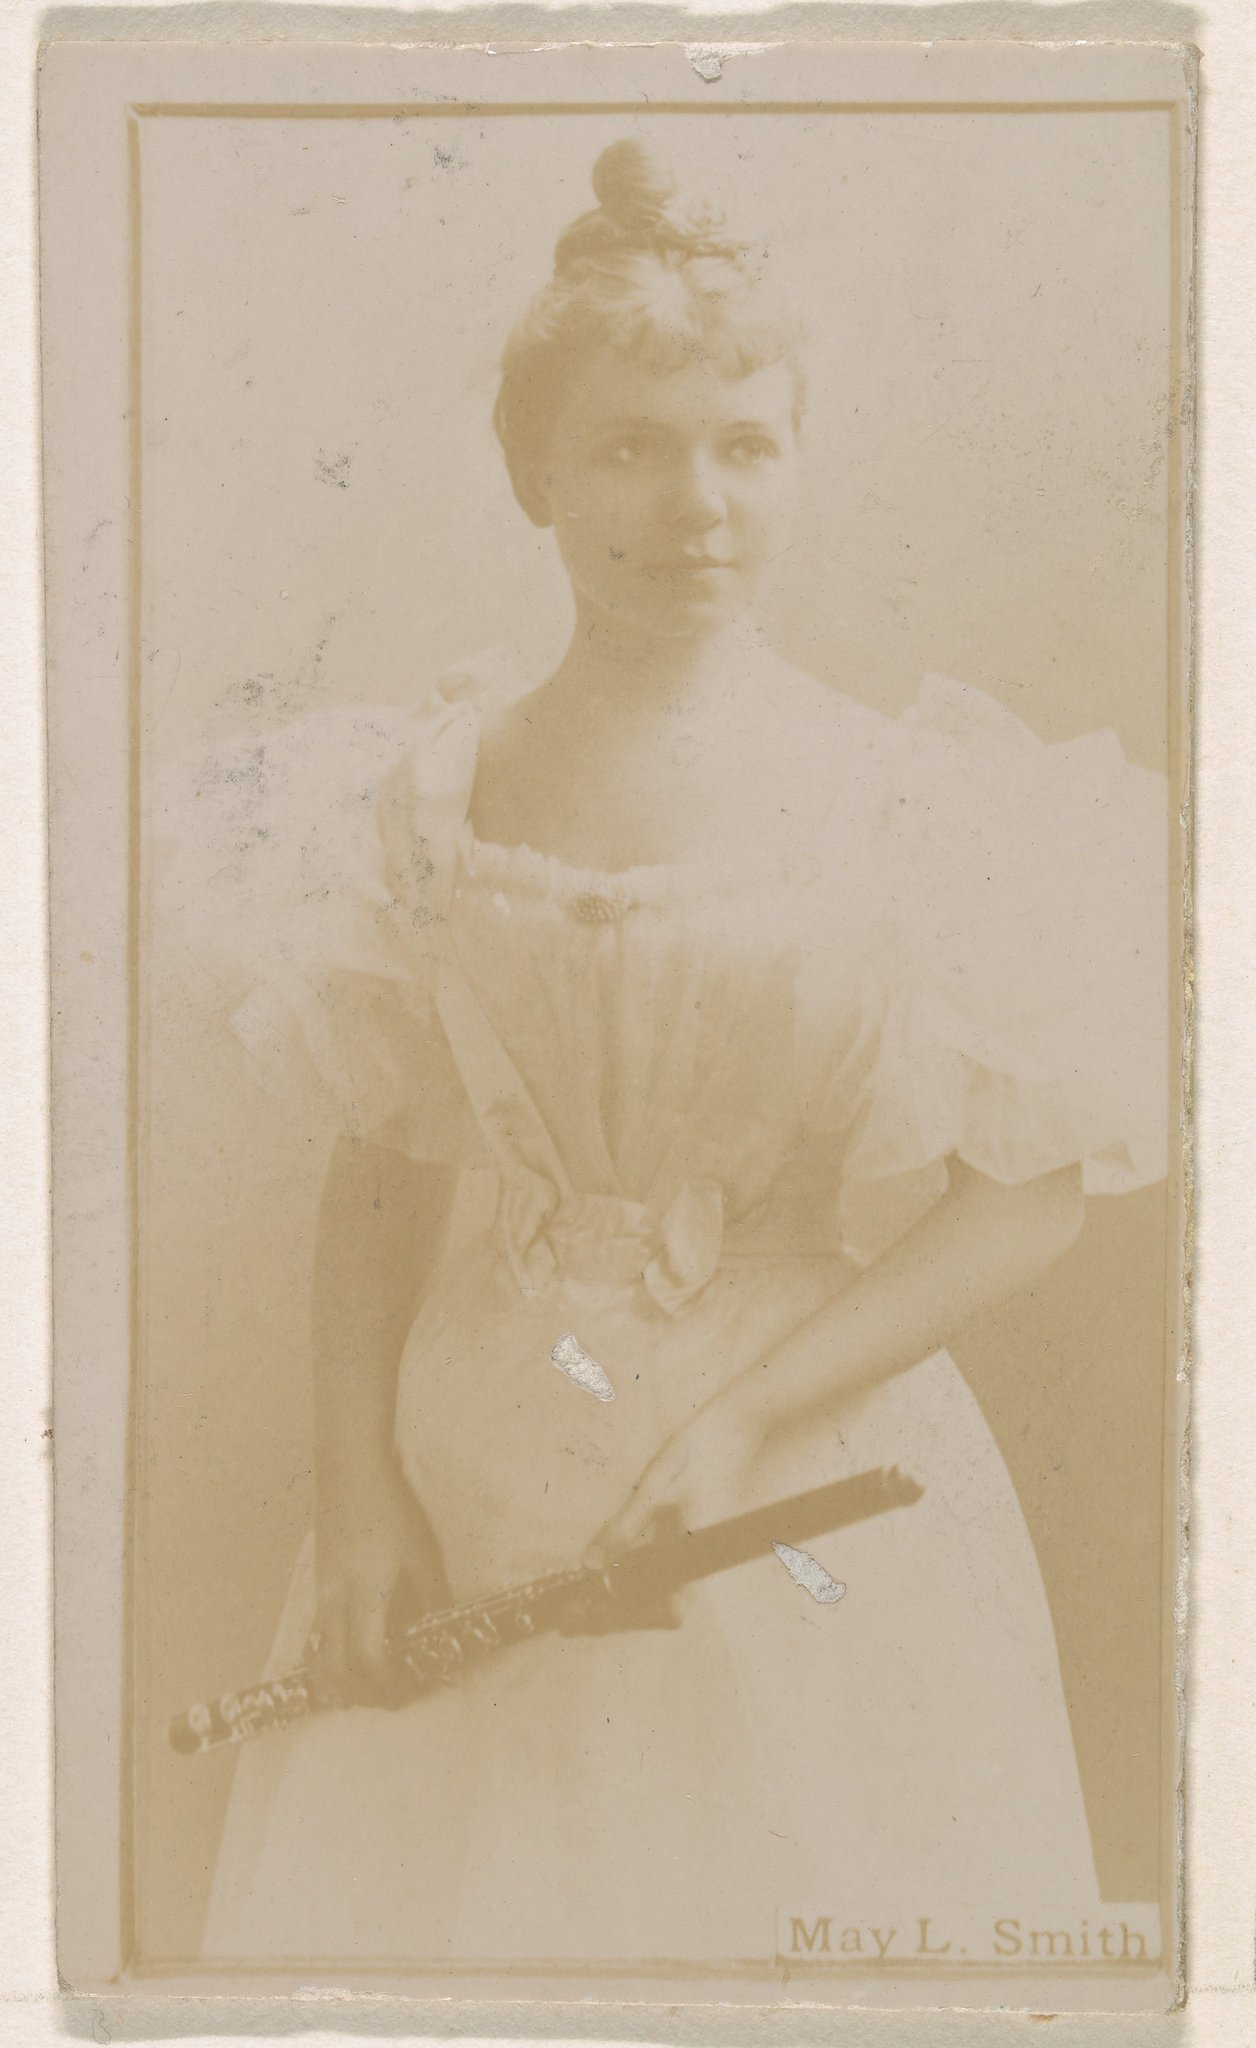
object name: photograph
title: May L. Smith, from the Actresses series (N245) issued by Kinney Brothers to promote Sweet Caporal Cigarettes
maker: kinney brothers tobacco company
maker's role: publisher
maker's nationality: american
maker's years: 1869-2011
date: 1890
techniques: albumen silver print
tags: portraits,women,actresses